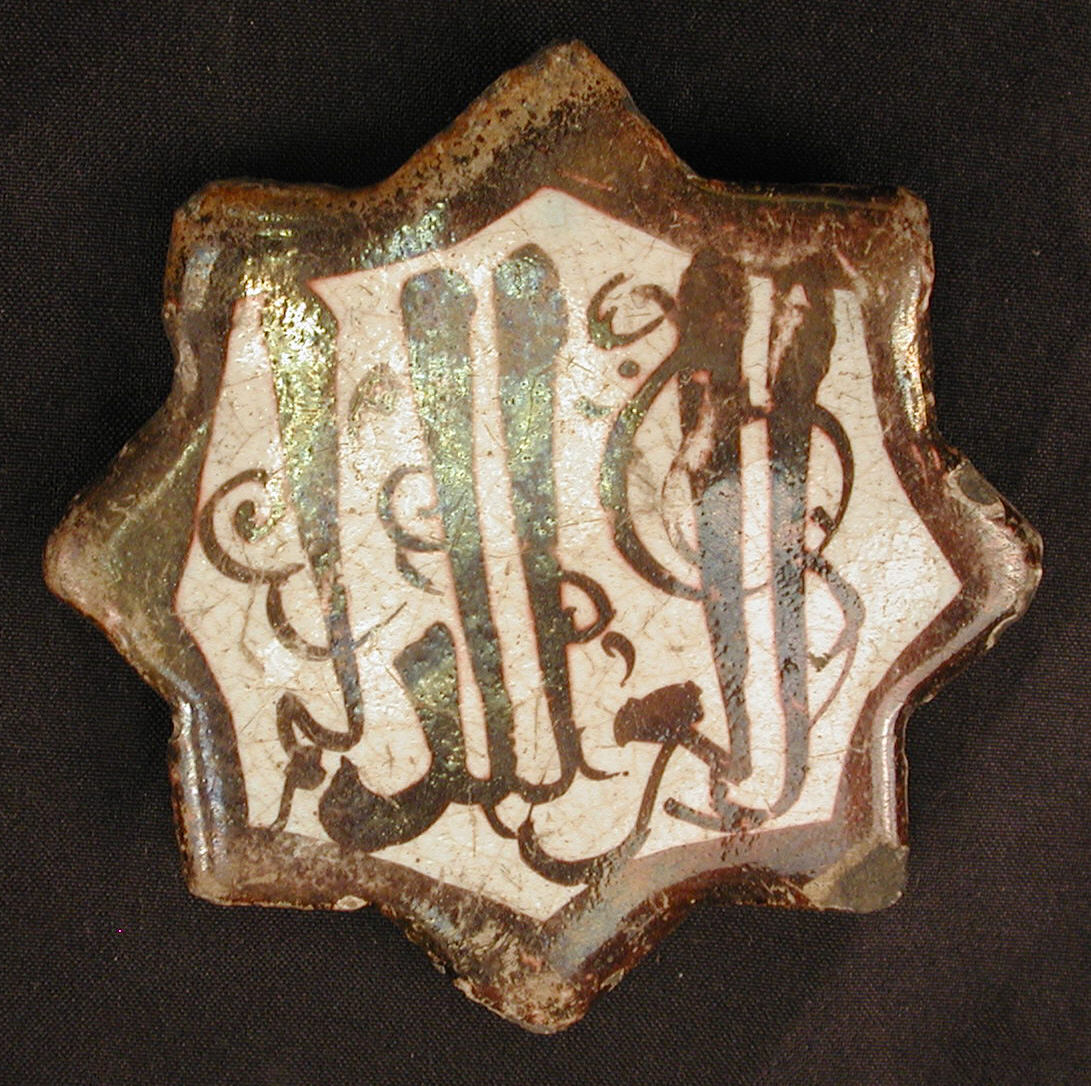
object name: tile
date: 1201-1250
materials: stonepaste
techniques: luster painting, overglaze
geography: iran